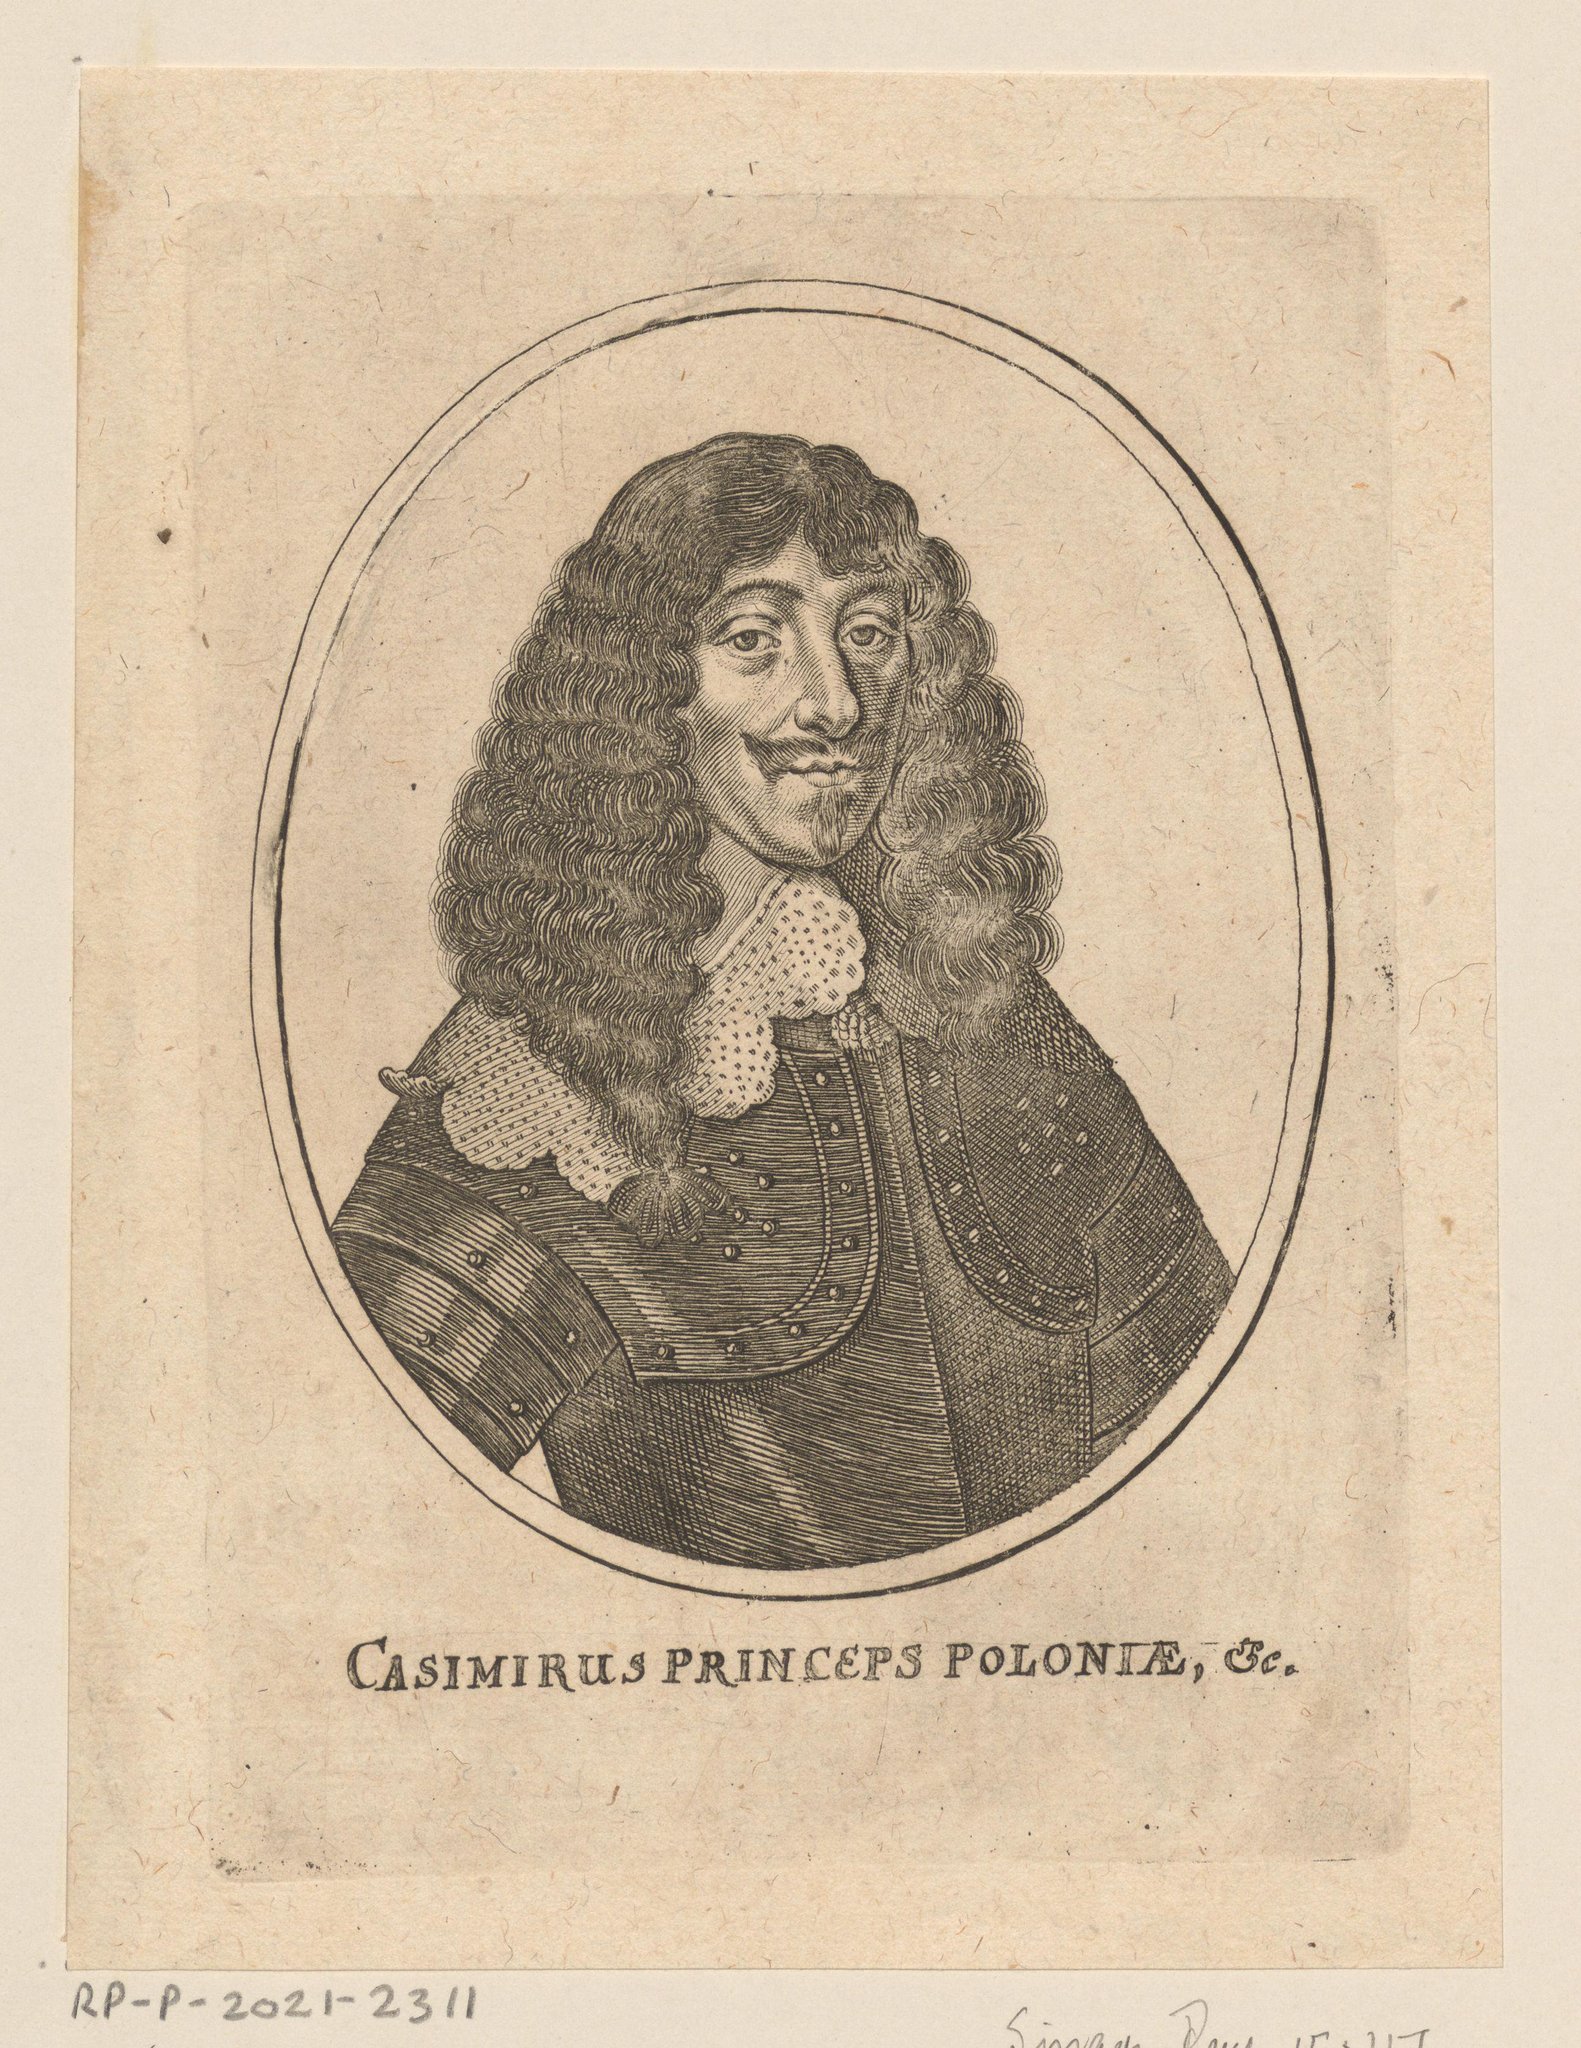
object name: print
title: Portret van Johan II Casimir, koning van Polen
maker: peter aubry (iii)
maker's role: print maker, publisher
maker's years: 1610-1686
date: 1647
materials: paper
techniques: engraving, etching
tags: historical persons, king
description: Prent met fleurons en tekst op verso gebruikt in: Abelin, Johann Philipp. Theatrum Europaeum. Frankfurt am Main: Matthäus Merian I, 1647, dl. 5.